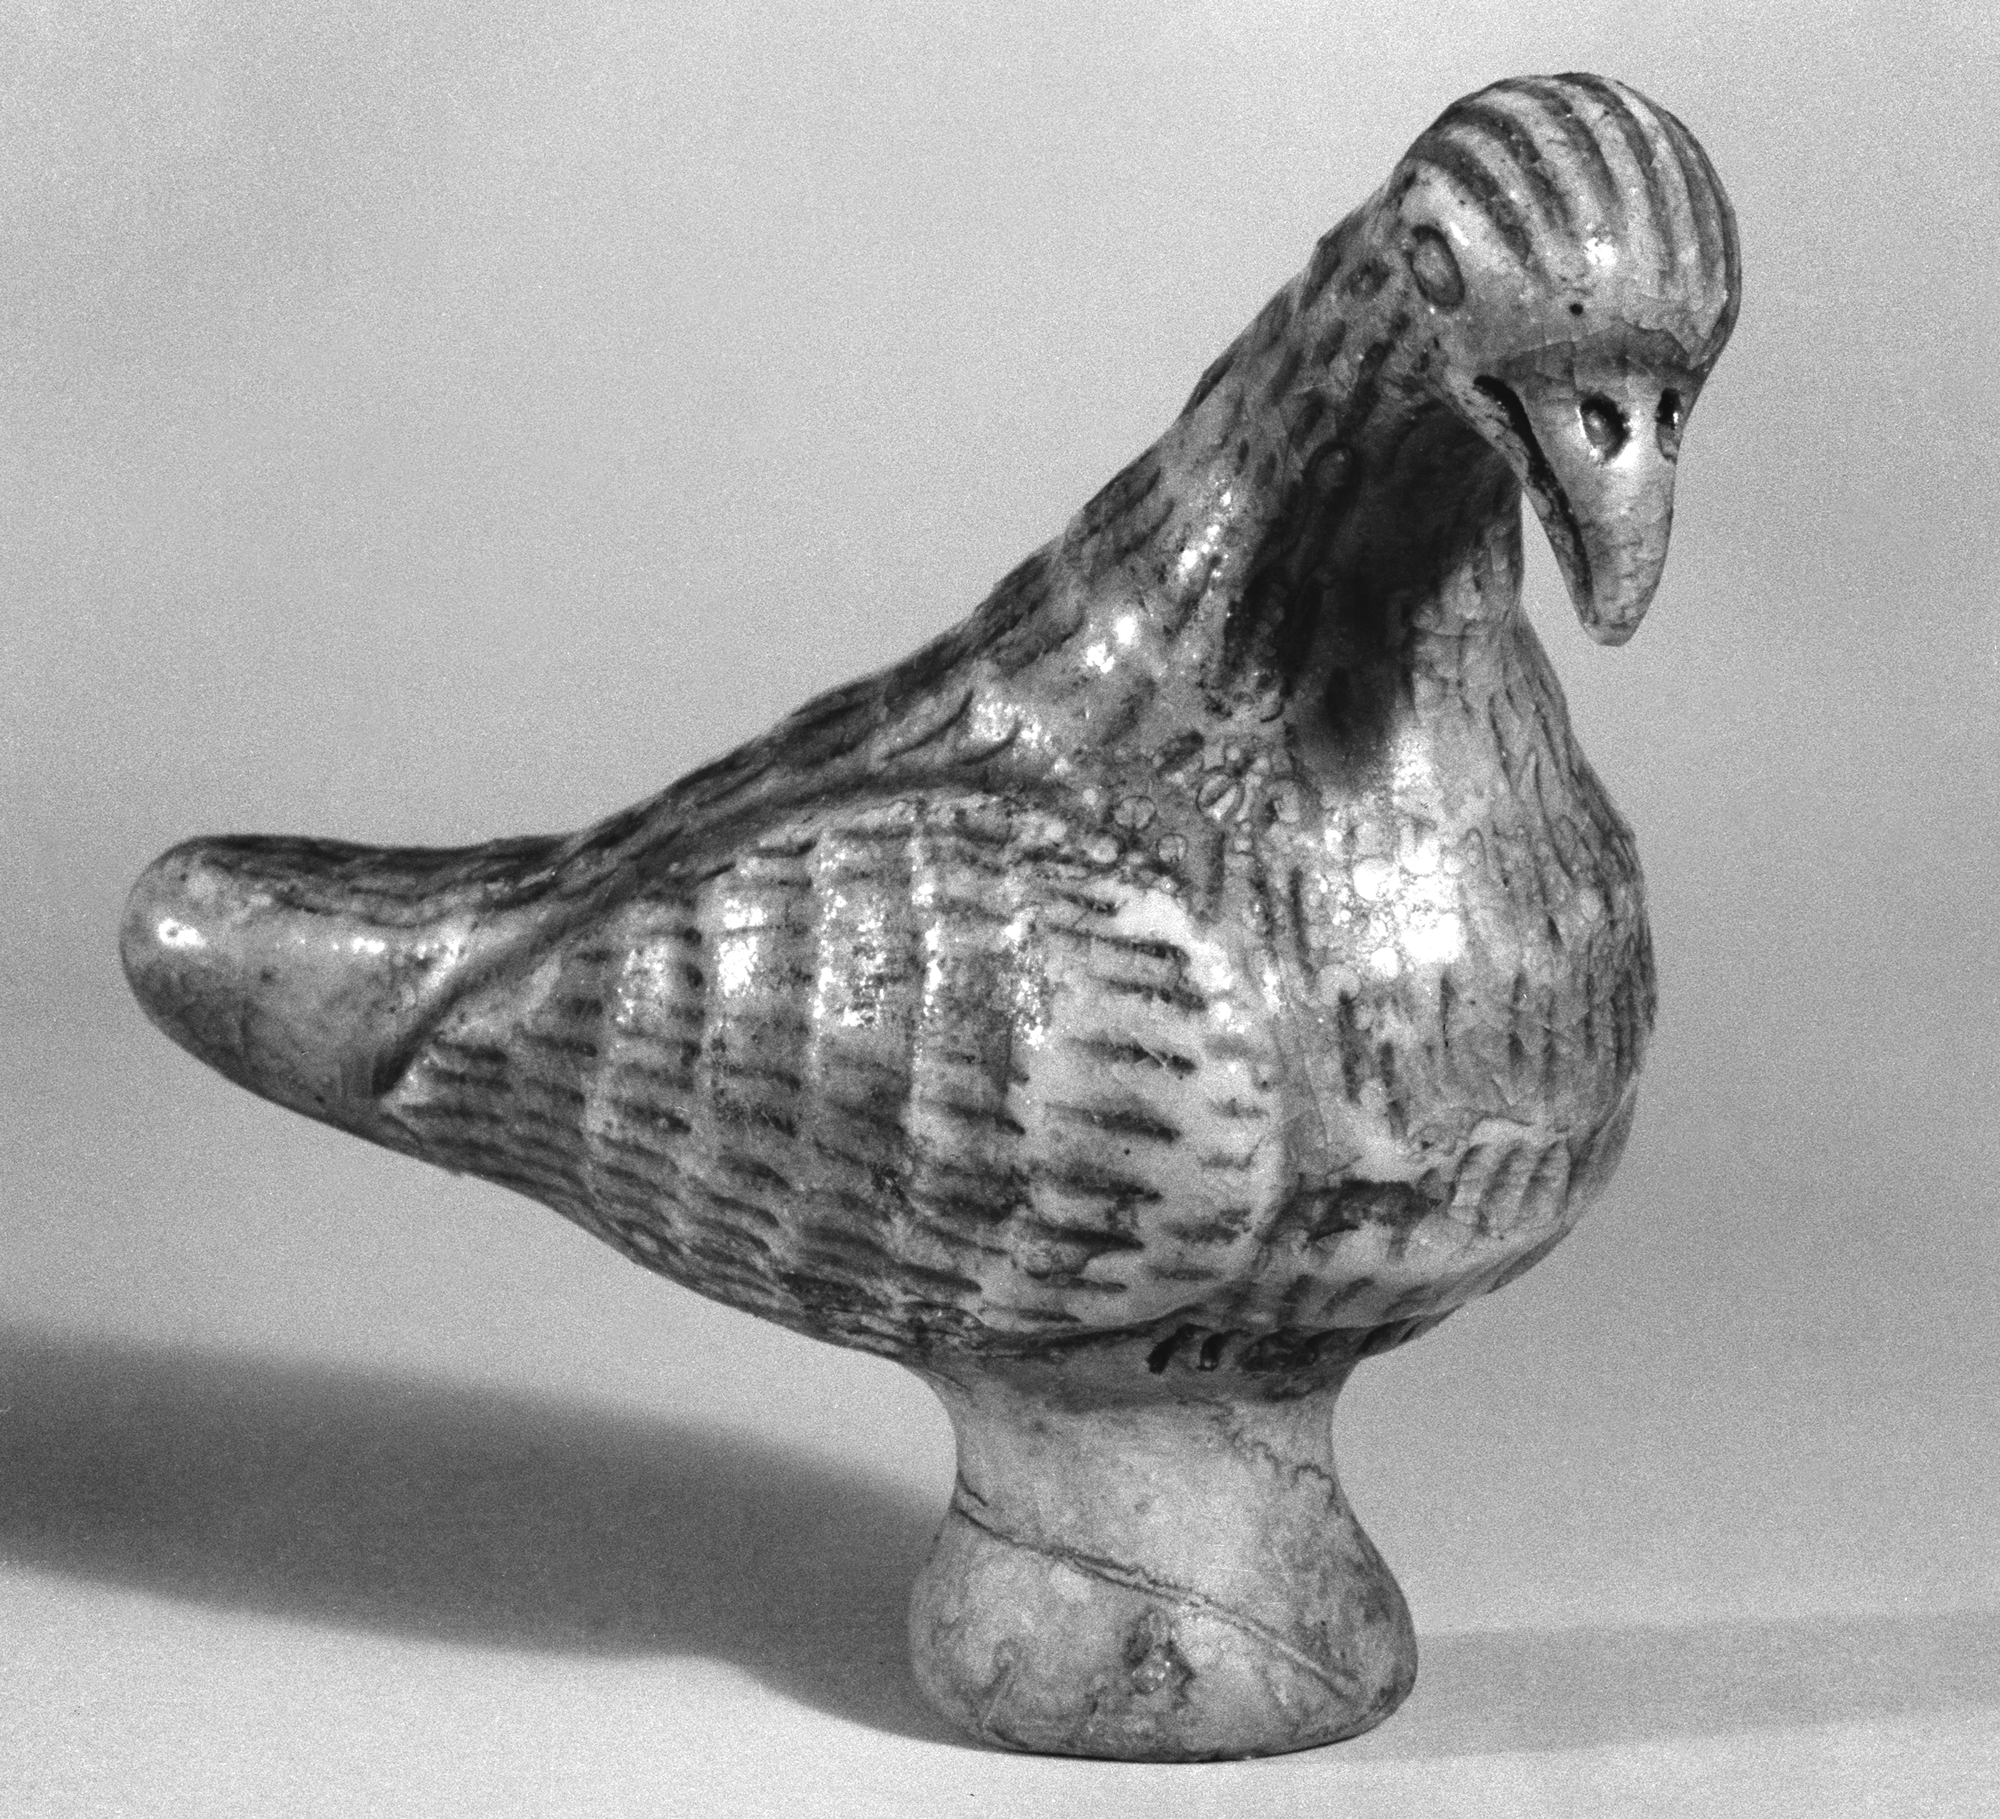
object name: figure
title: Bird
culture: thai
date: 1301-1500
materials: earthenware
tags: birds